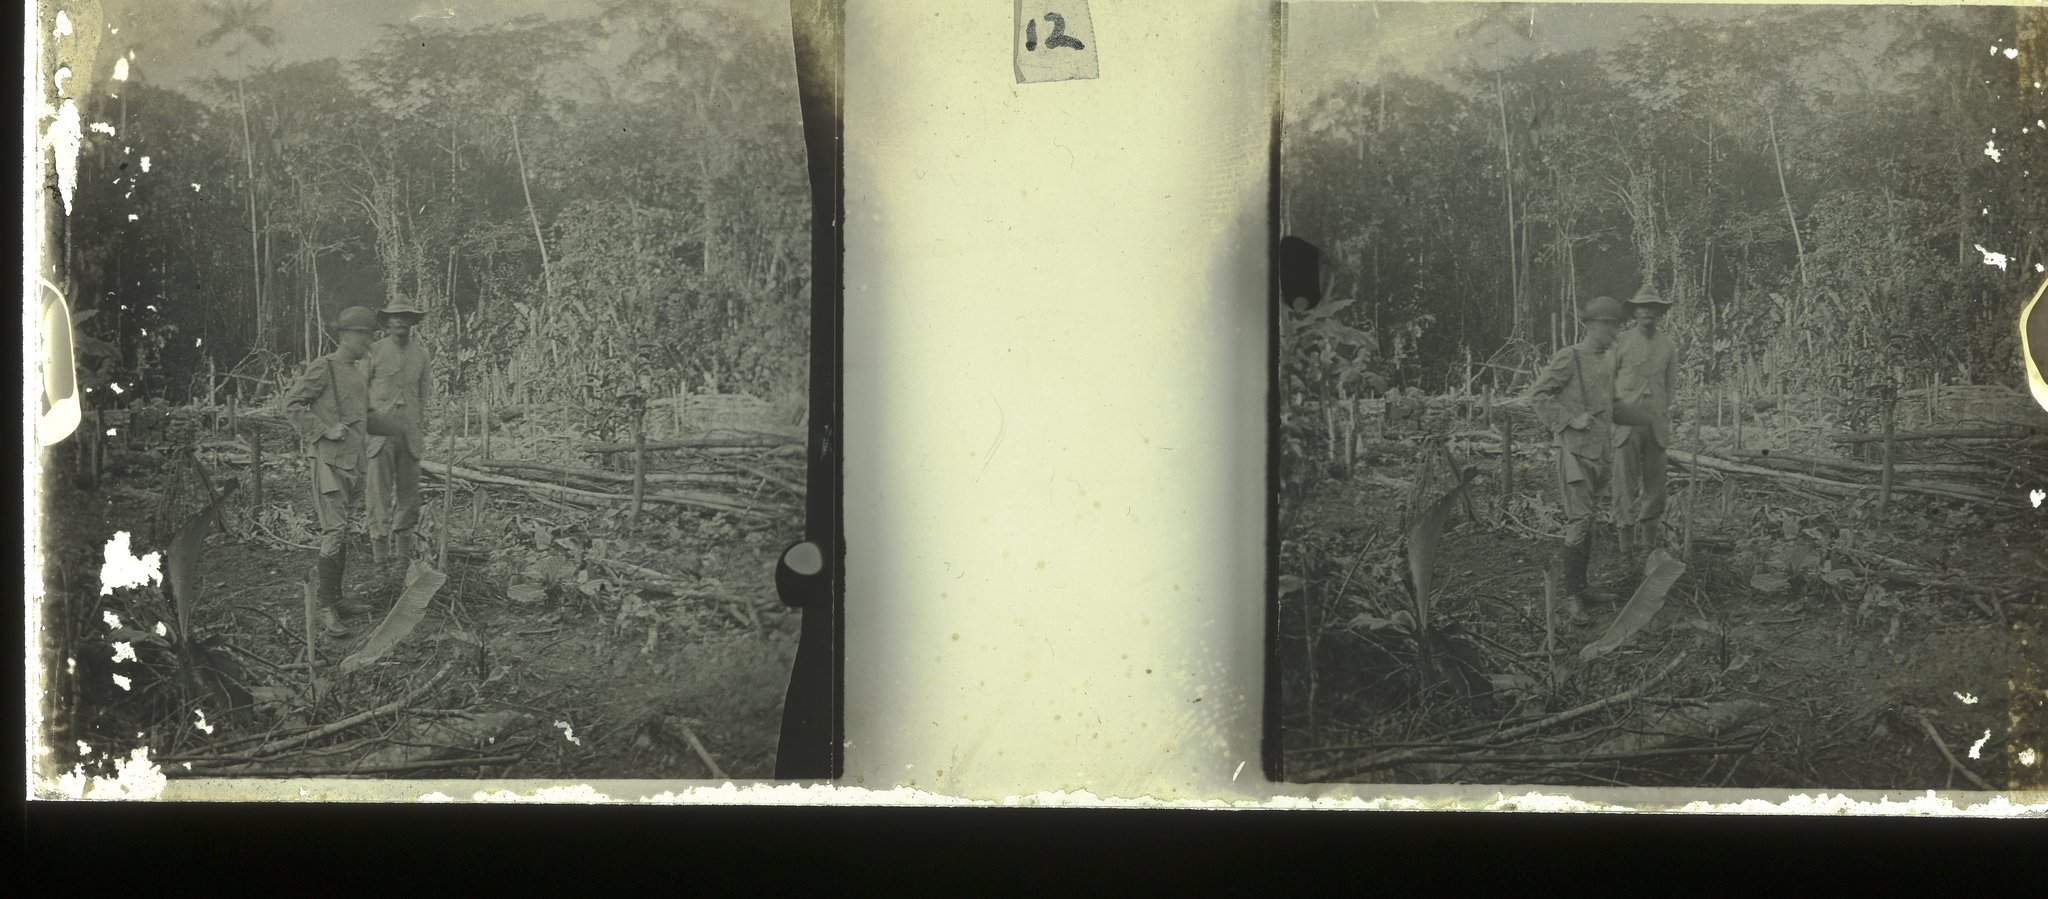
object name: stereograph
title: Plantage Accaribo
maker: theodoor brouwers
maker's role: amateurfotograaf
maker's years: 1874-1932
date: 1913-1930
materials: glass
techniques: photography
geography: suriname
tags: amsterdam, theodoor brouwers, plantation, suriname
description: In de periode 1911-1932 woonde op plantage Accaribo in Suriname de familie Brouwers van wie de foto's afkomstig zijn. Rond 1910 vond Theodoor Brouwers werk op plantage Accaribo. In 1929 werd hij eigenaar van de plantage. Op Accaribo werden in zijn tijd bananen geproduceerd en wat koffie.